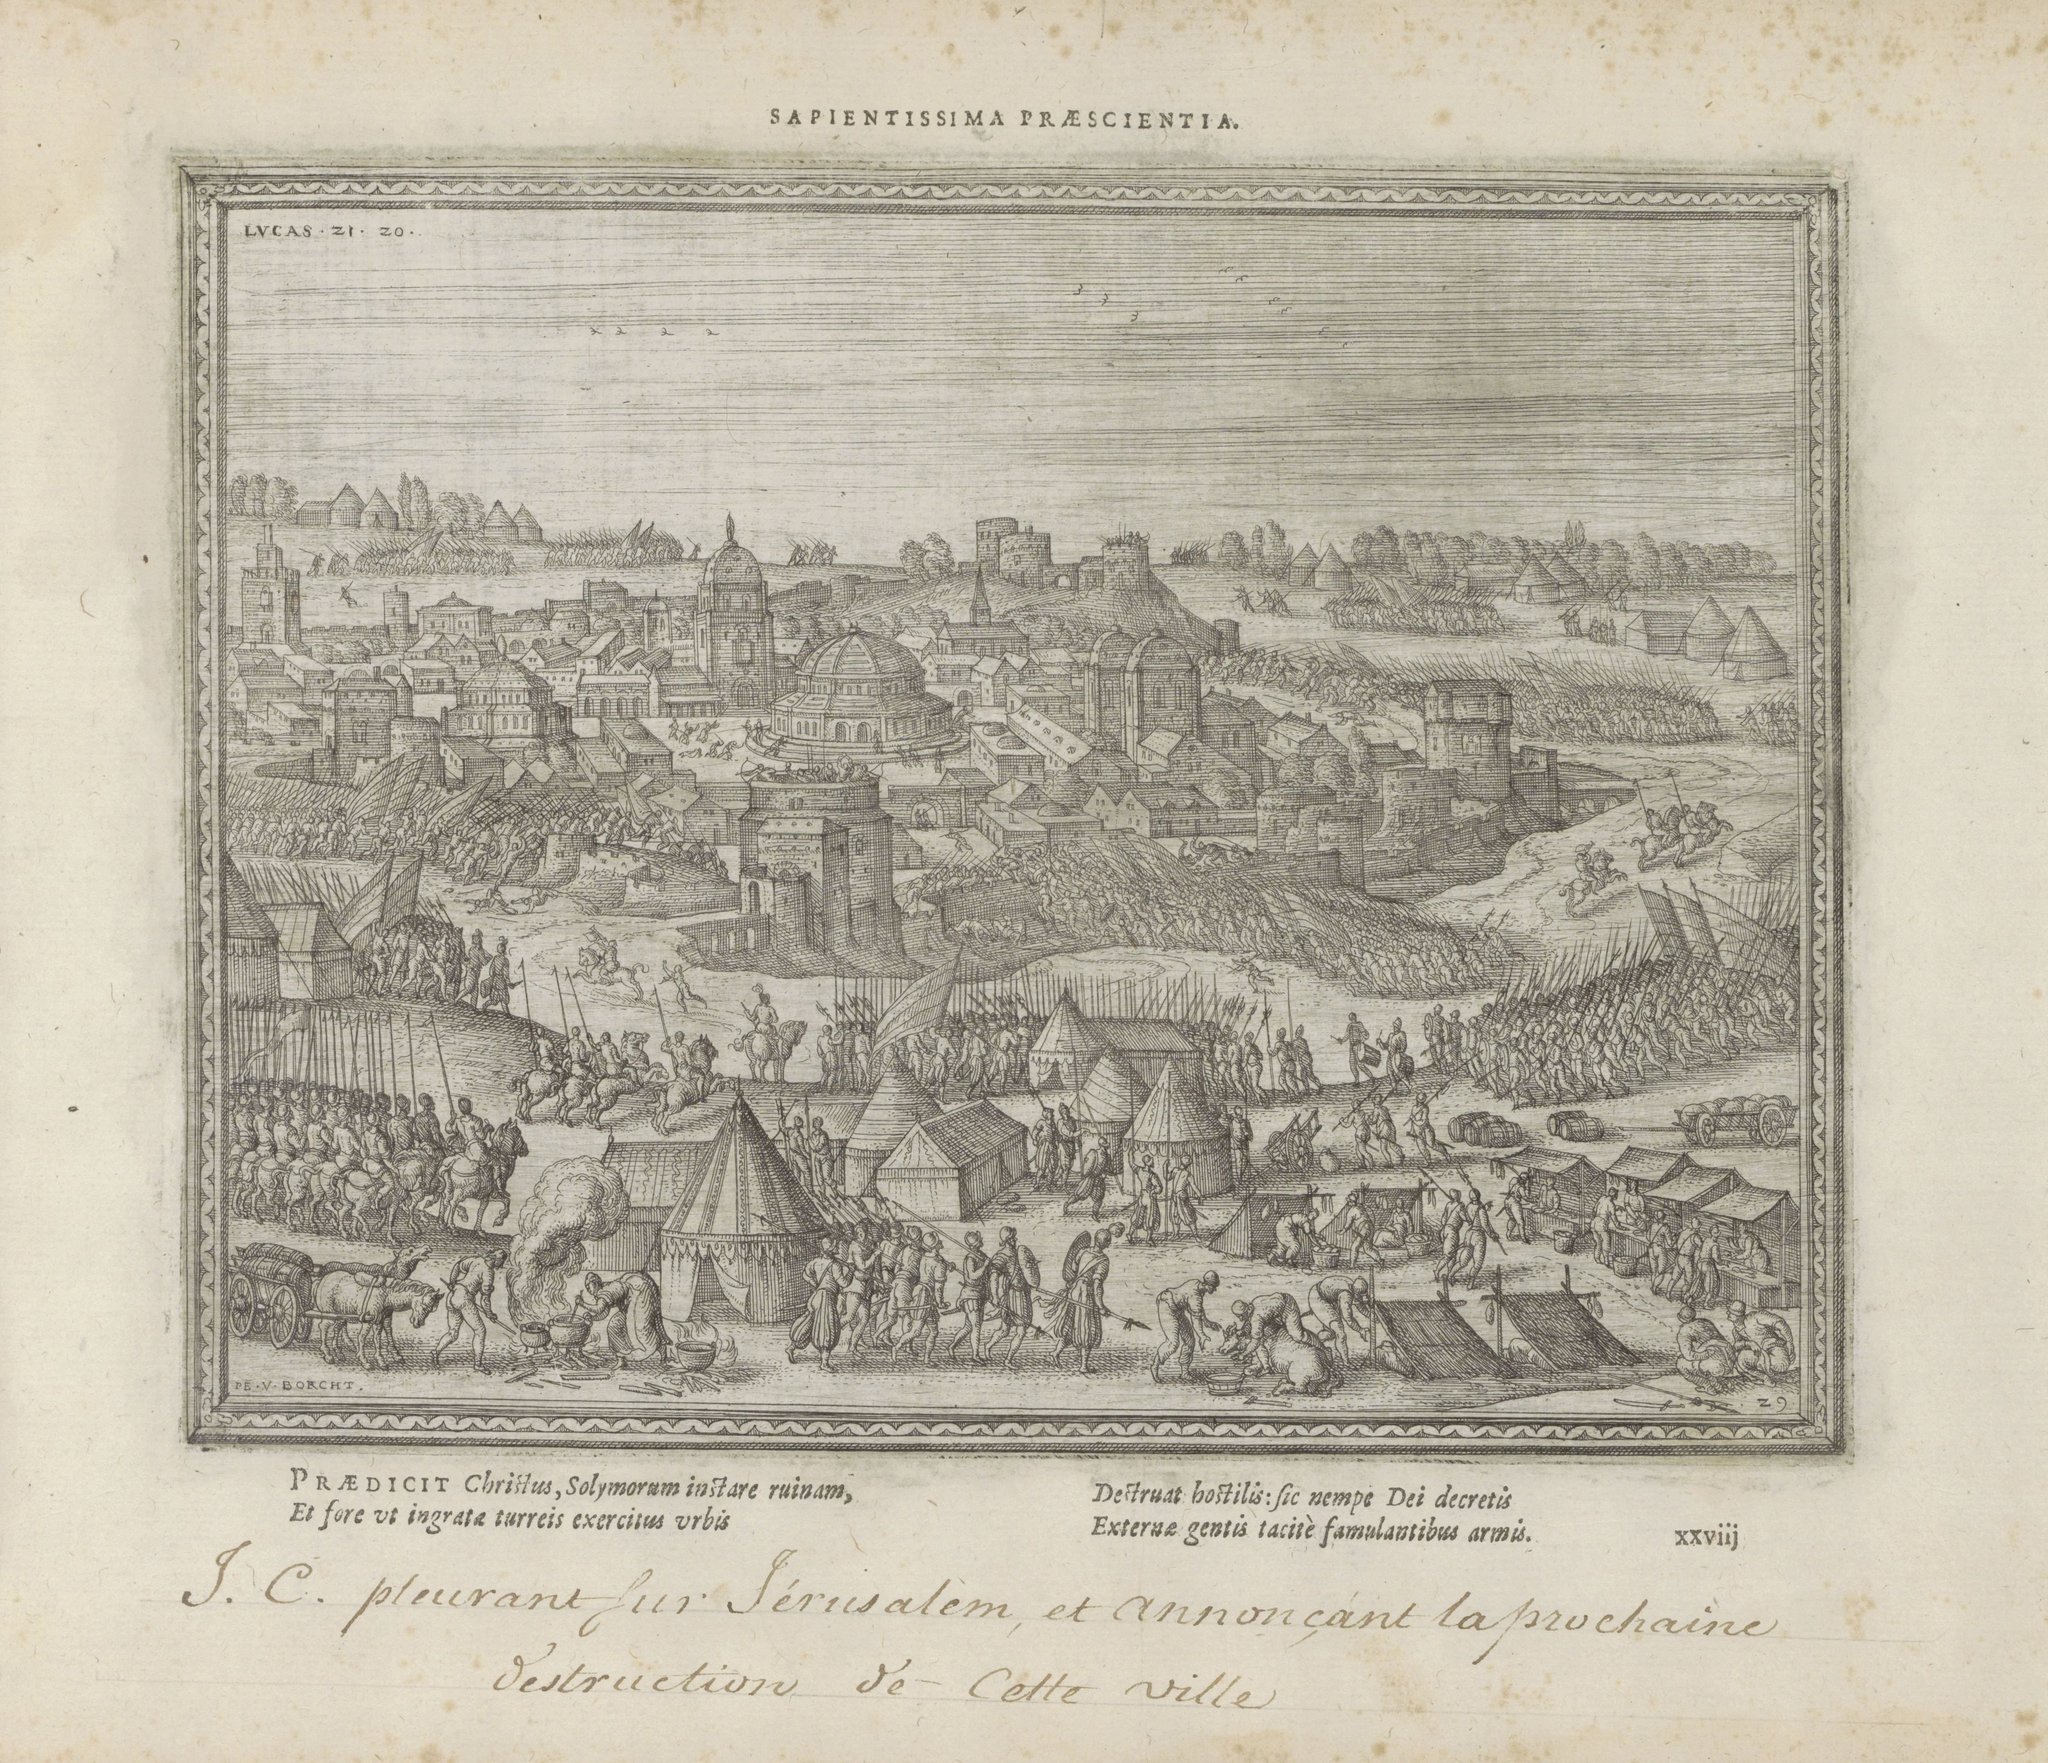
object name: print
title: Sapientissima praescientia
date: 1582-1593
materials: paper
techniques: etching, letterpress printing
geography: antwerp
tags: signs in nature and in the sky prophesying the destruction of jerusalem (luke 21:25)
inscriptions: inscription: ‘J.C. pleurant sur Jérusalem, et annoncant la prochaine destruction de cette ville’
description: Jeruzalem is door legertroepen omsingeld. Christus voorspelde dat bij deze aanblik de verwoesting van de stad nabij is (Luc. 21). Linksonder legt een man hout op het vuur en staat een vrouw in een pot te roeren. Rechtsonder twee poepende mannen op hun hurken. Met een motto in het Latijn boven de voorstelling en een vierregelig onderschrift in het Latijn onder de prent. De prent maakt deel uit van een album.